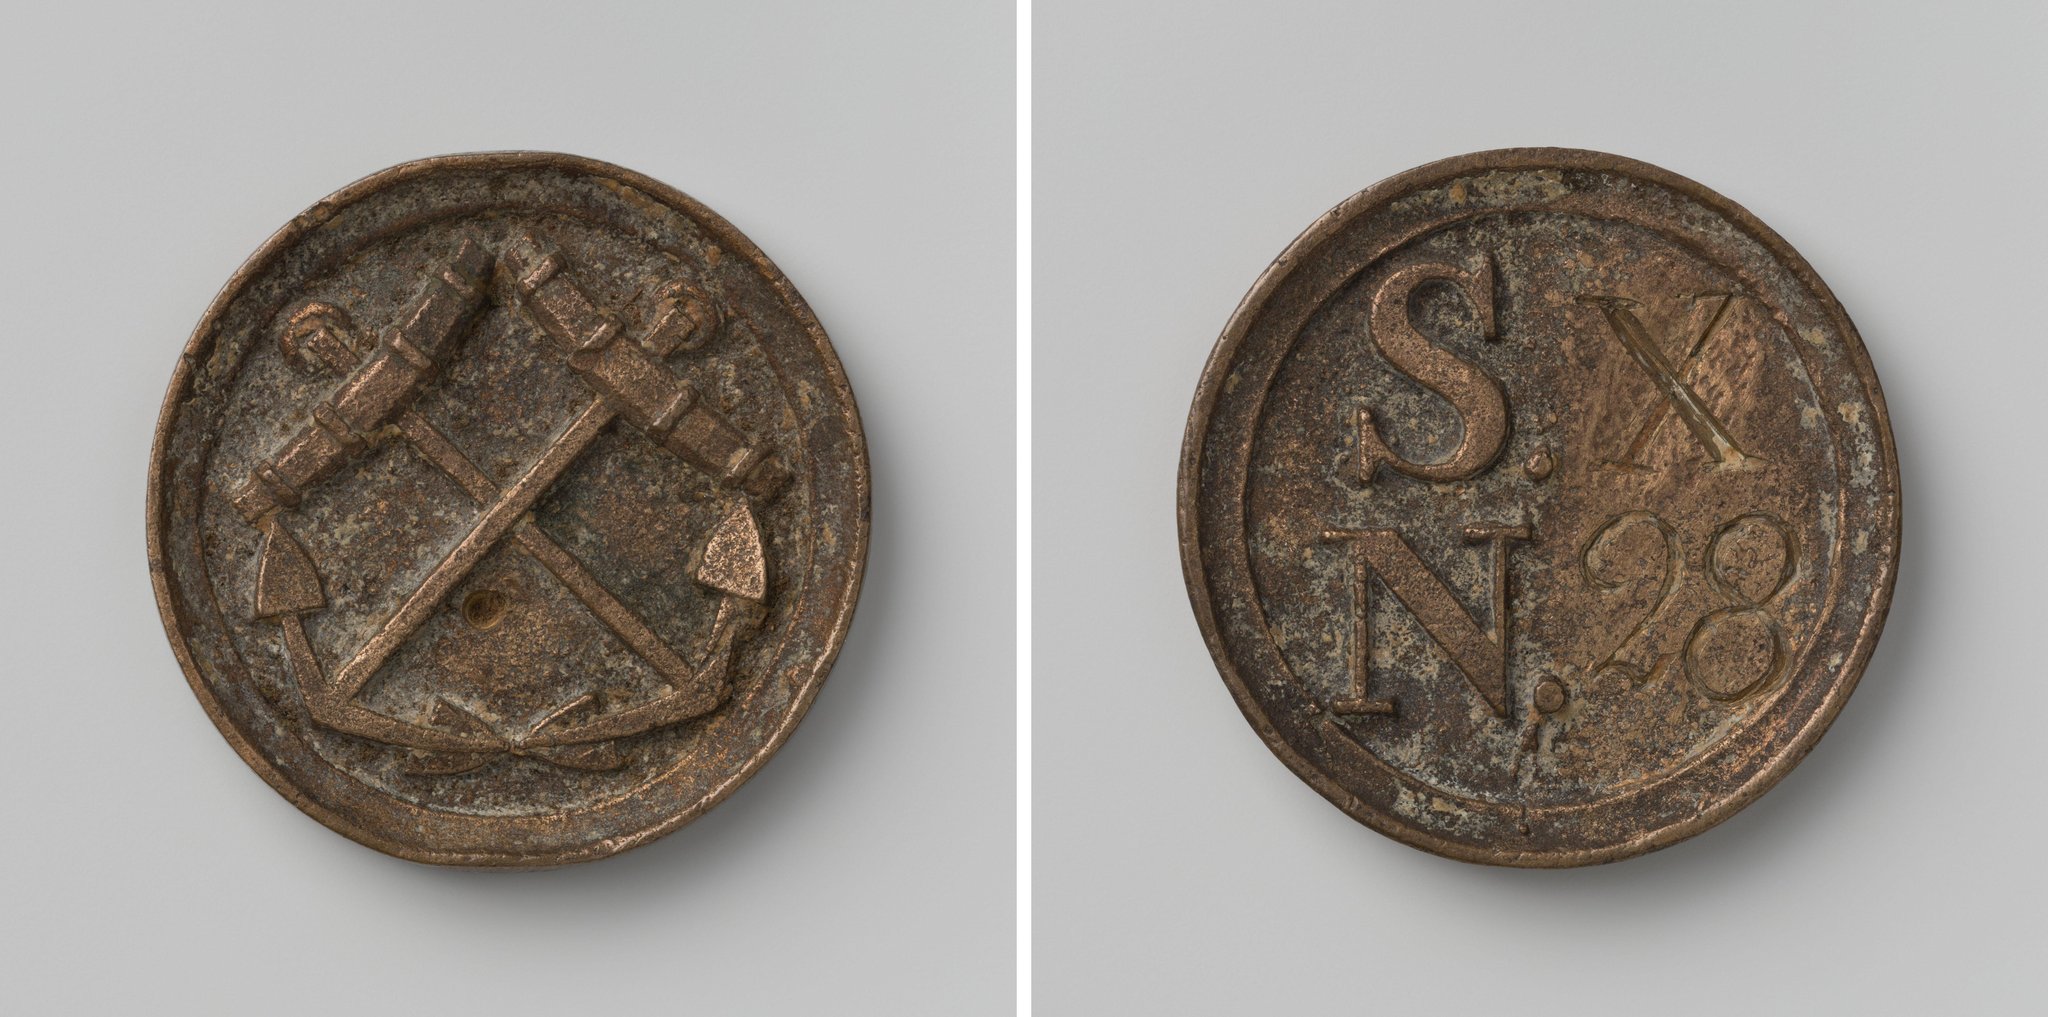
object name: fire engine medal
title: Marinewerf van Amsterdam, brandspuitpenning van spuit 10, no. 28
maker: Anonymous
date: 1680-1795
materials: brass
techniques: casting, engraving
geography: amsterdam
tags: amsterdam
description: Messing penning. Voorzijde: twee gekruiste ankers. Keerzijde: opschrift S. X; daaronder opschrift N. 28